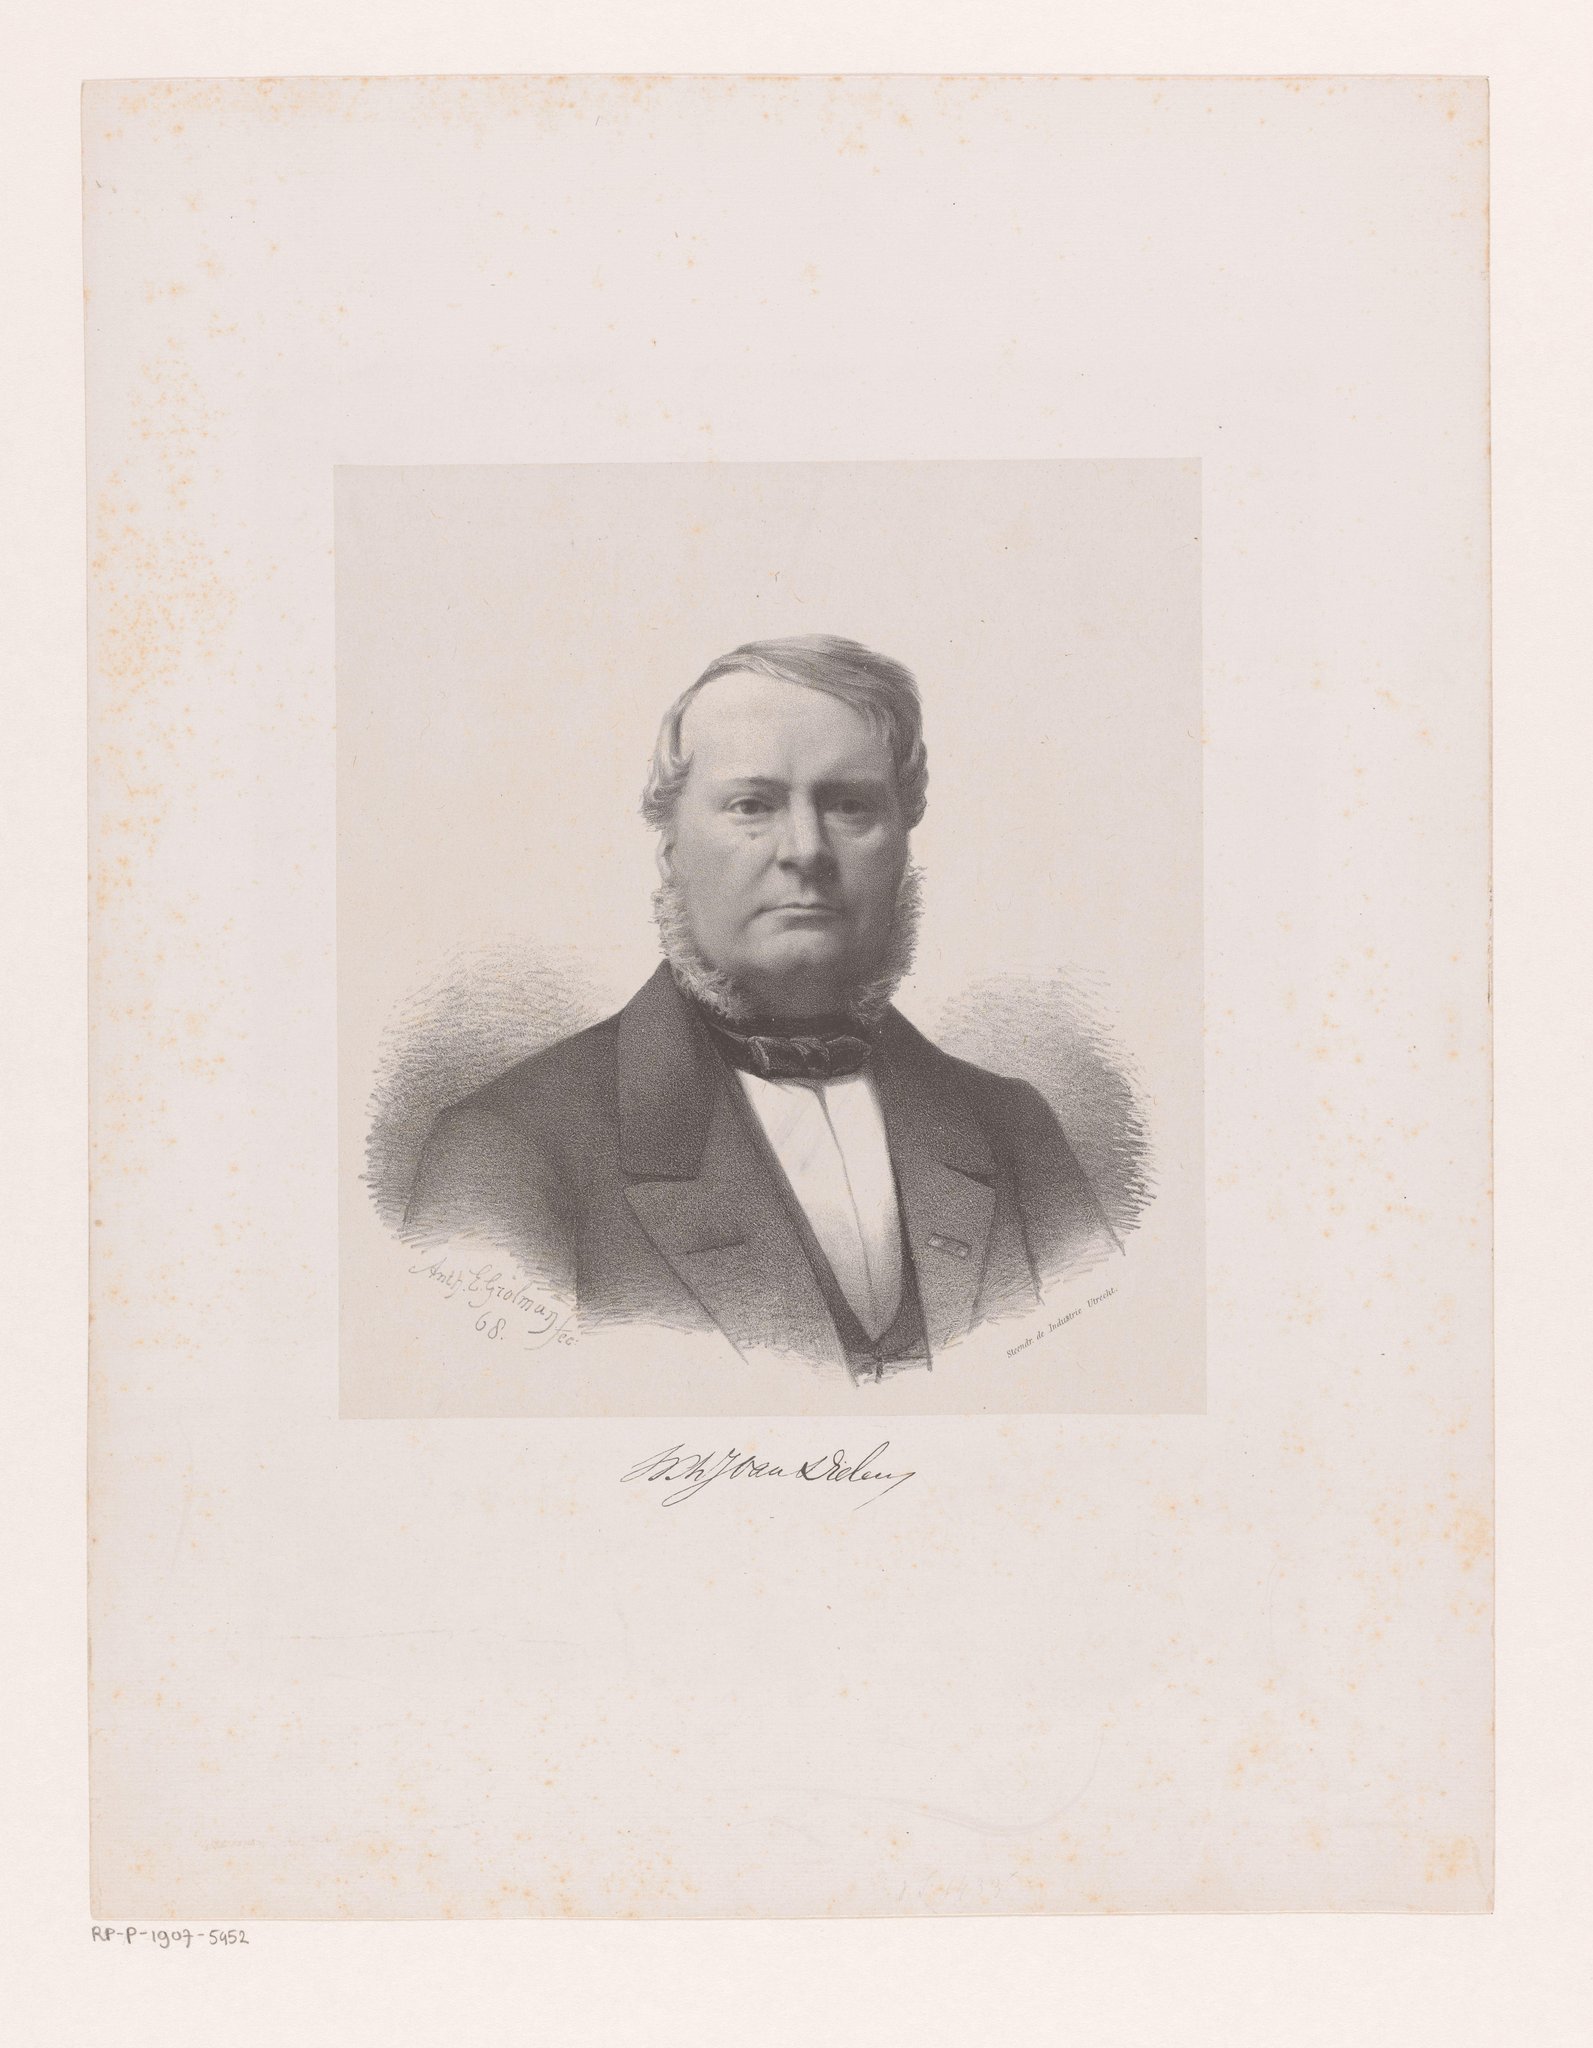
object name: print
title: Portret van een onbekende man, mogelijk W. Ph. J. van Dielen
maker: anthony grolman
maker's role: draughtsman, print maker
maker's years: 1843-1926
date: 1868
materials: paper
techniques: lithograph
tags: historical persons (+ head (and shoulders) (portrait)), knighthood order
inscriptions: collector's mark: Lugt 2228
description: De geportretteerde draagt bakkebaarden en een ordeteken op de revers van zijn jas.